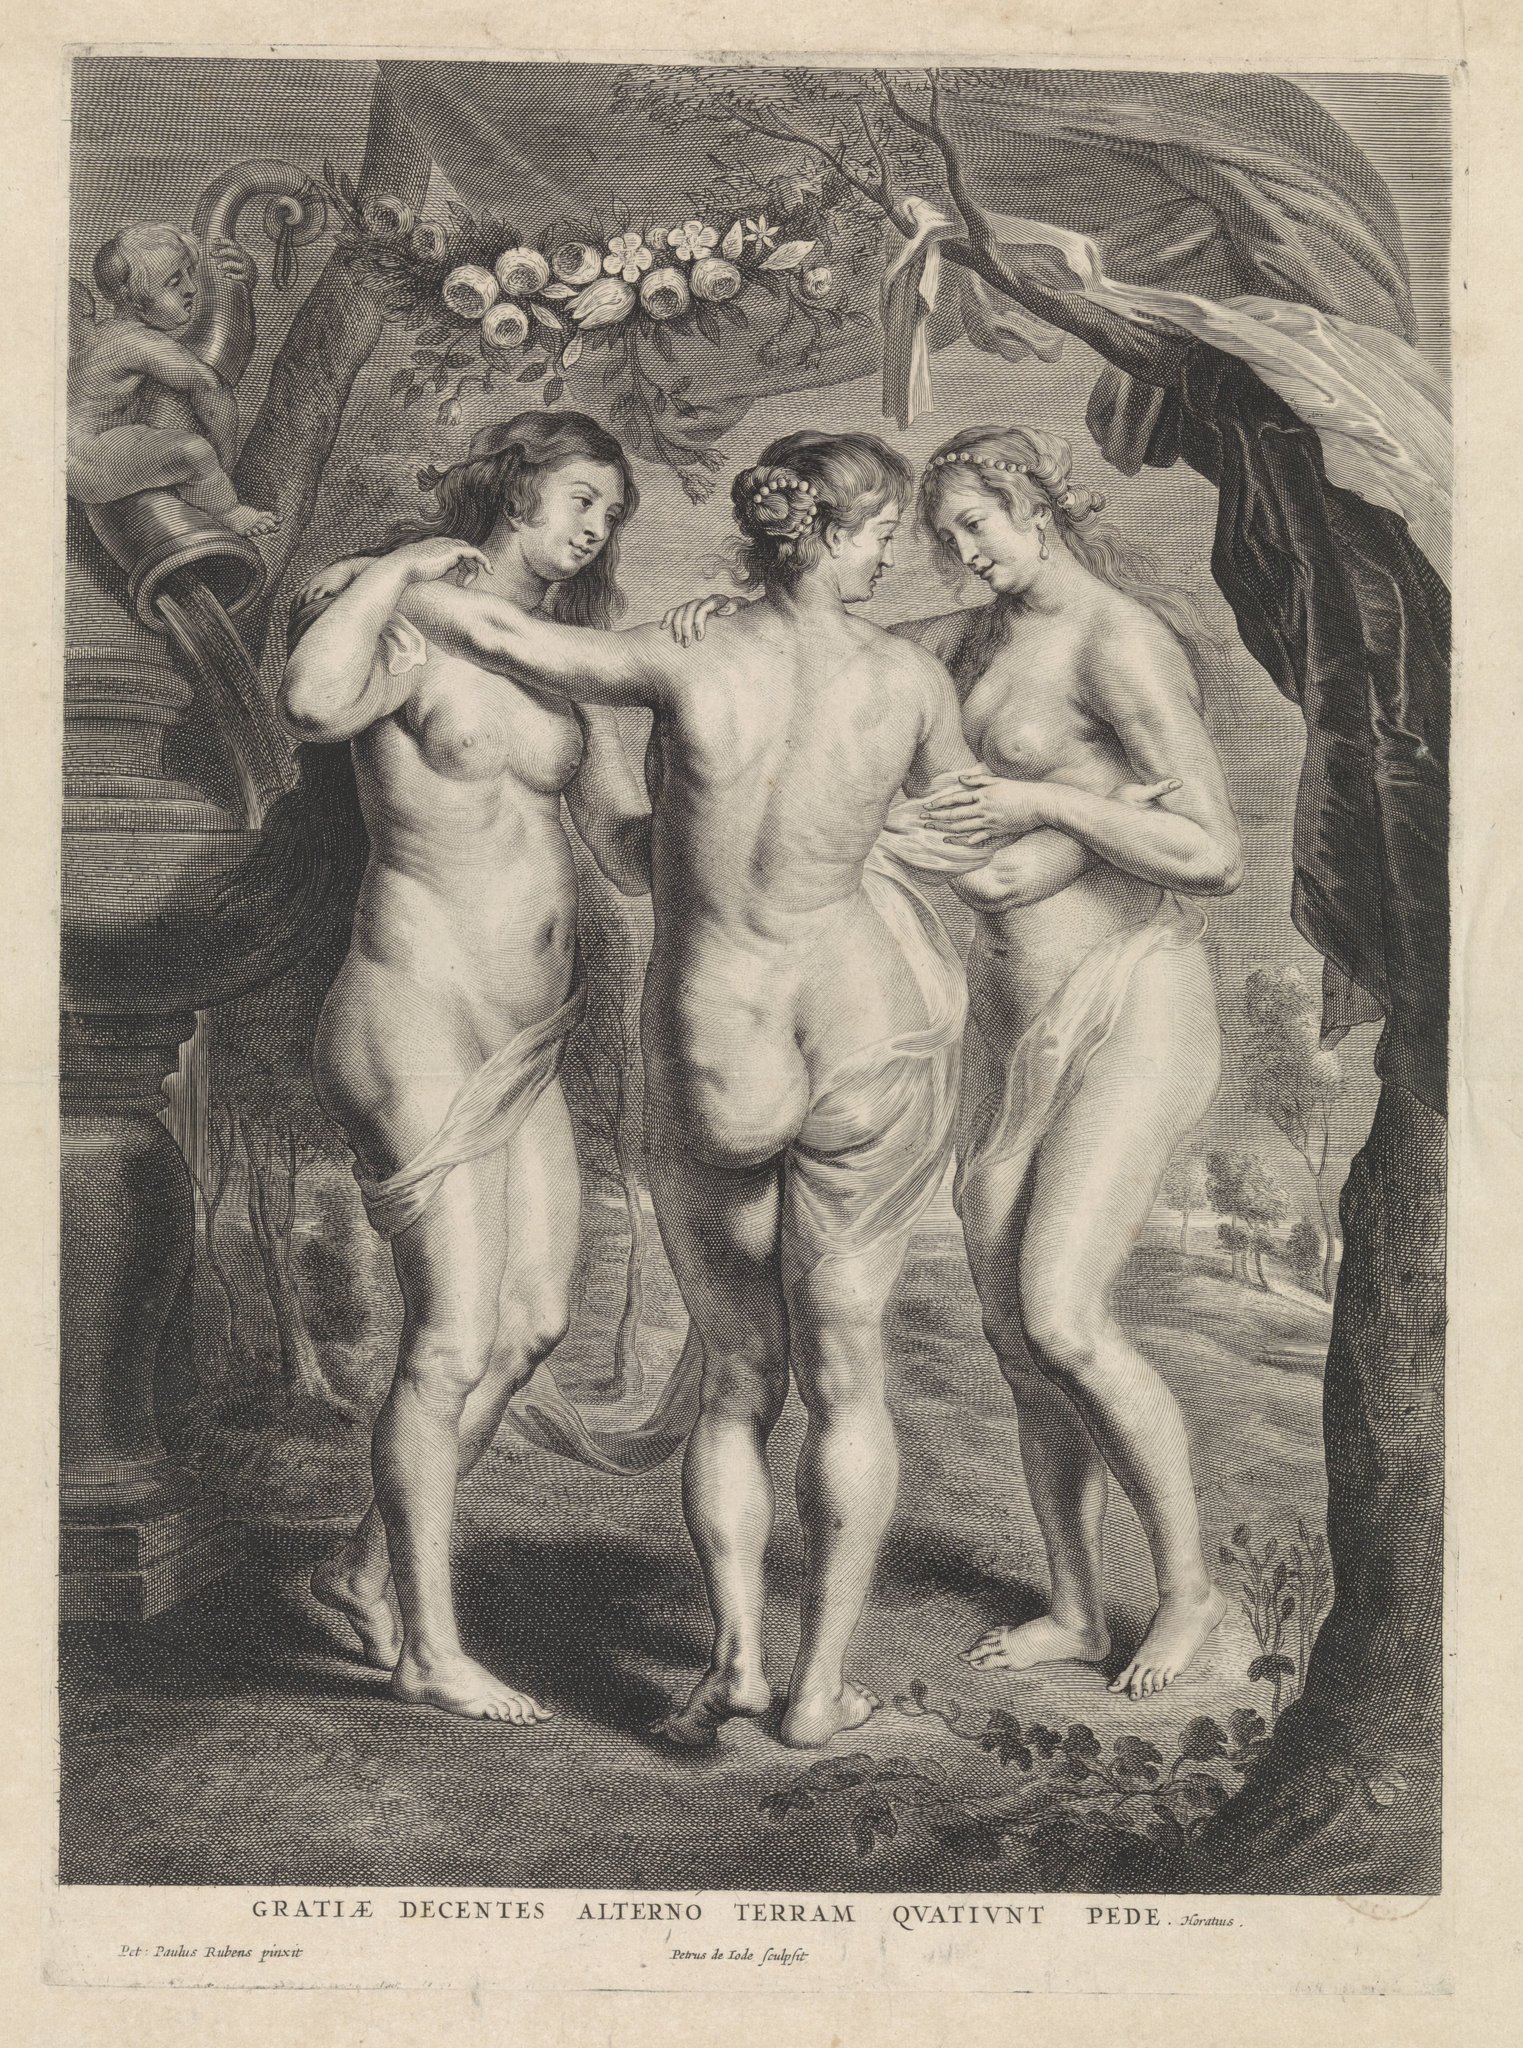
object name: print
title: Landschap met de Drie Gratiën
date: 1628-1670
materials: paper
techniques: engraving, etching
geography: antwerp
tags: graces (charites), generally three in number; 'gratie' (ripa)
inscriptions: collector's mark: Lugt 240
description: Landschap met de drie Gratiën, de middelste op de rug gezien. Ze staan met de armen over elkaars schouders. Boven hen een bloemenkrans die tussen een boom en een fontein met putto hangt. In de marge een onderschrift in het Latijn.